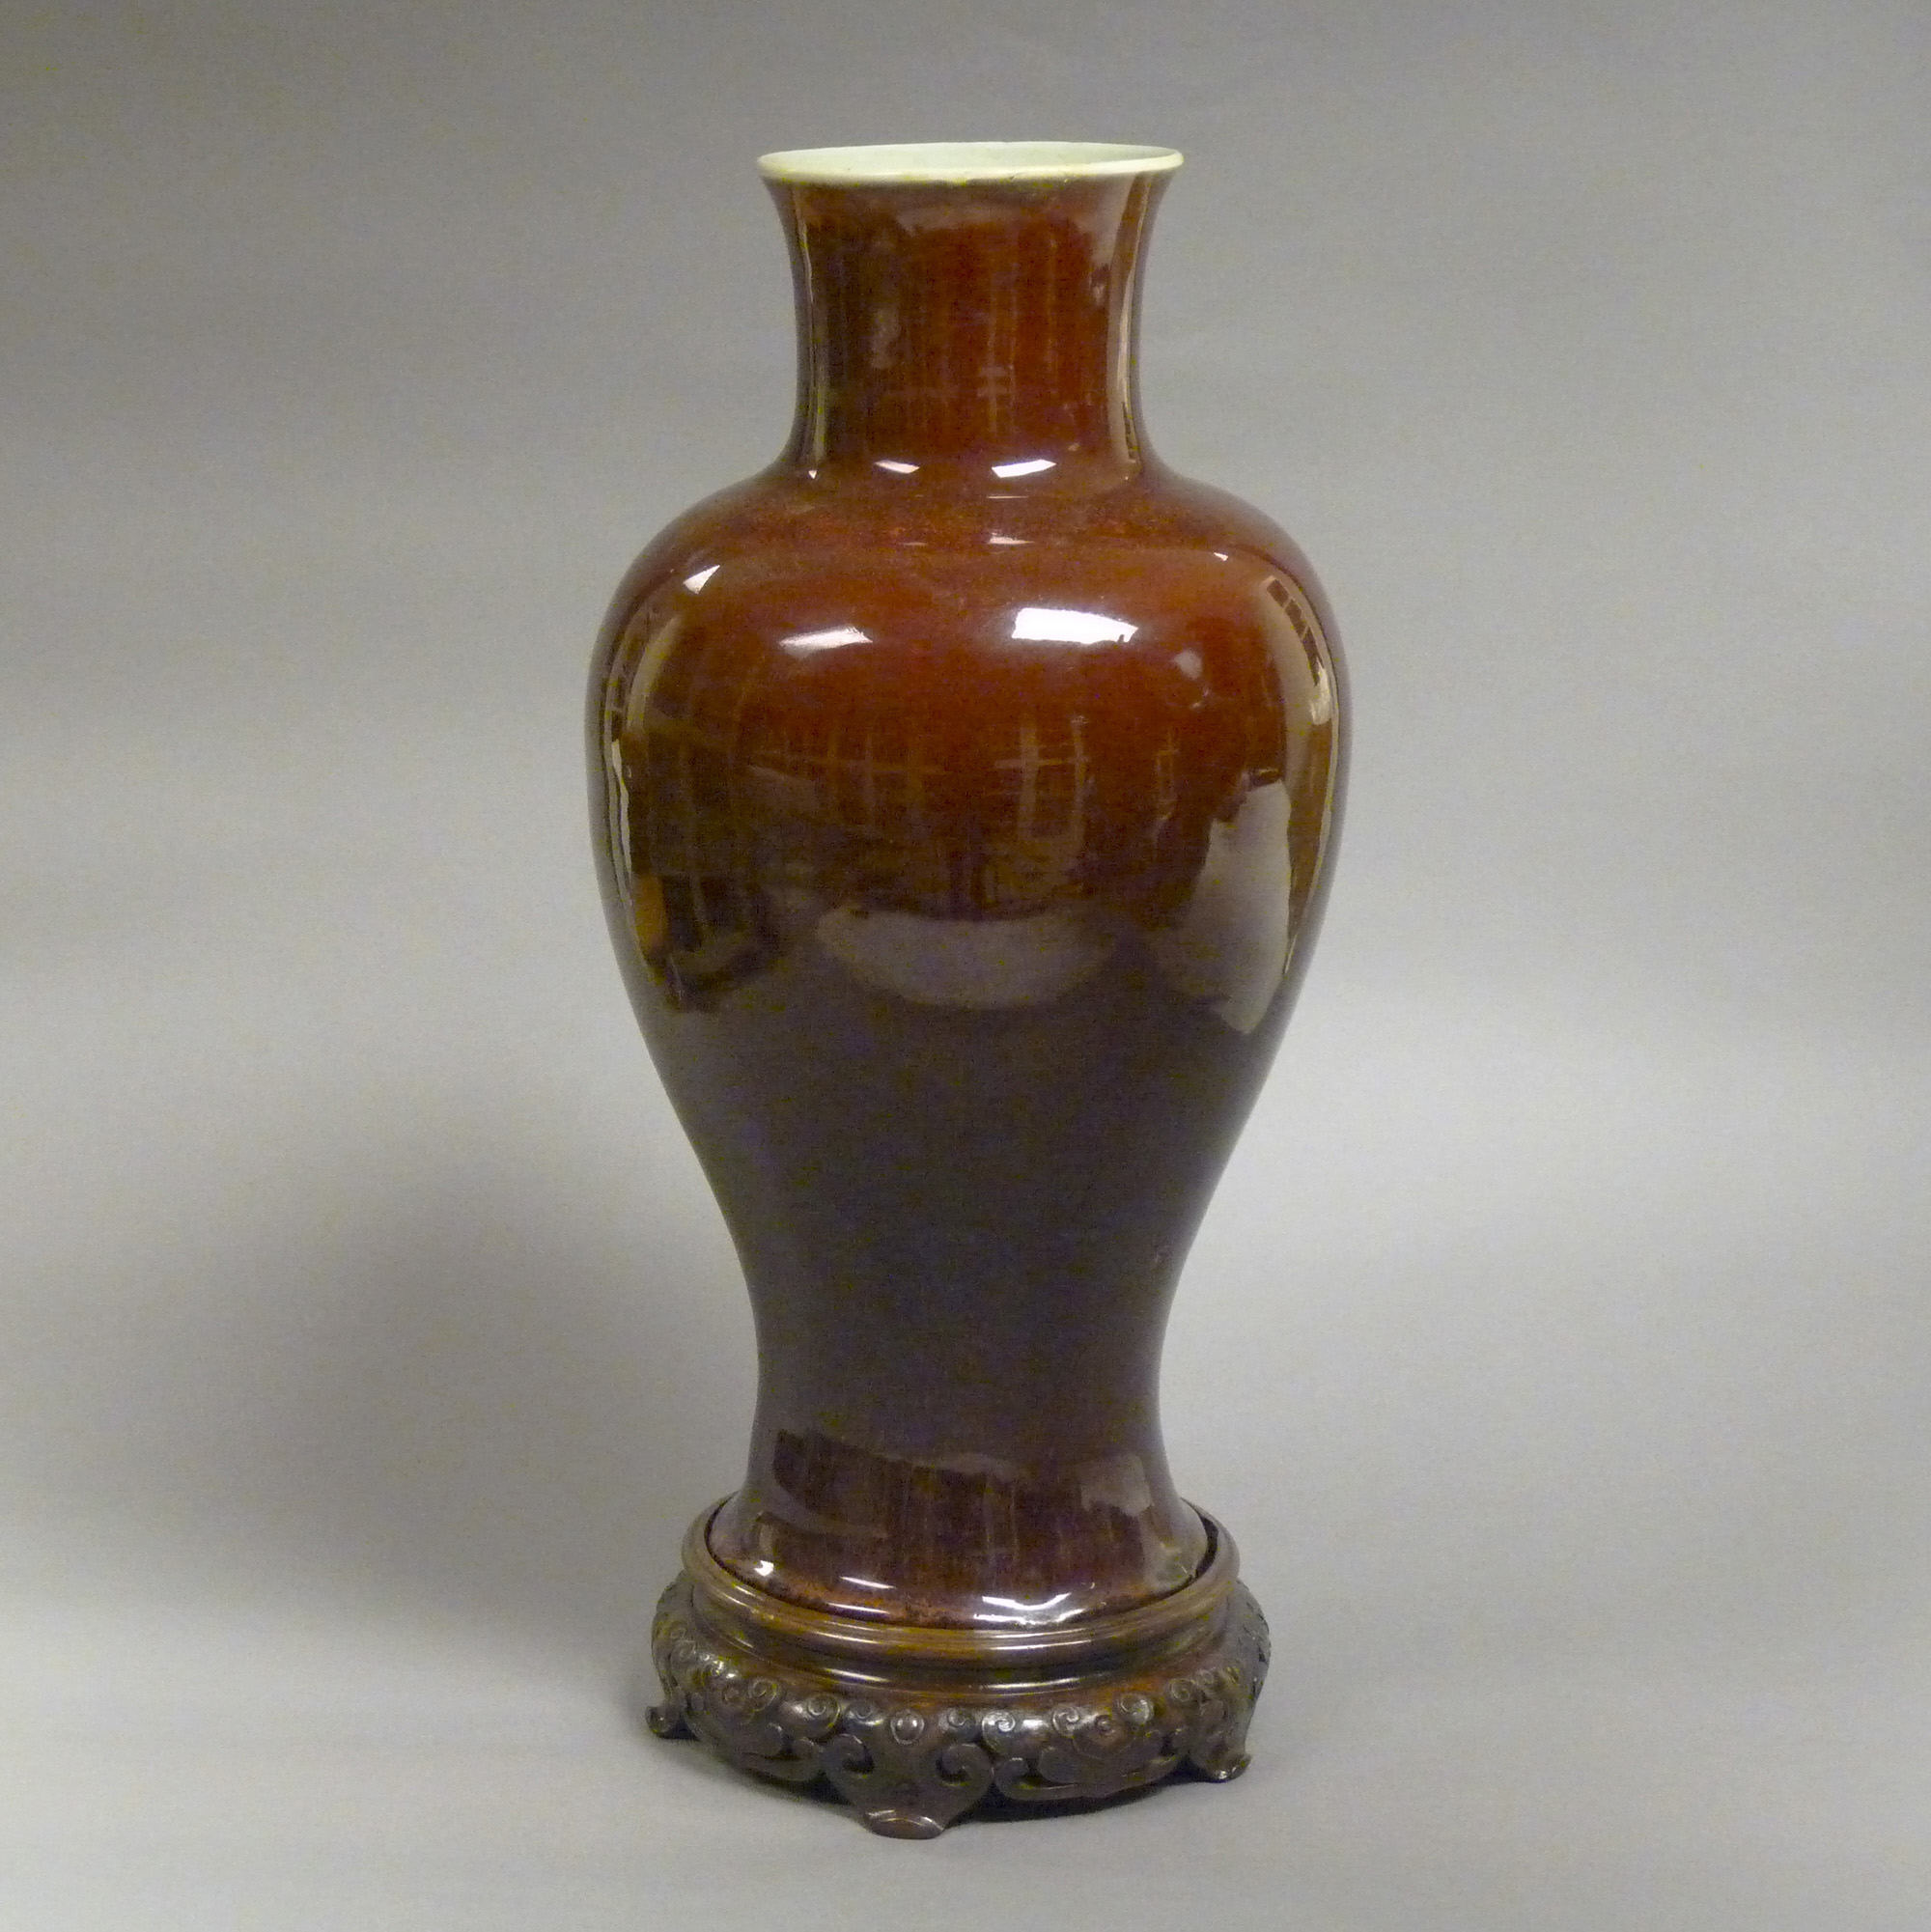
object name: vase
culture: chinese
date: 1701-1800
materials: glaze, porcelain